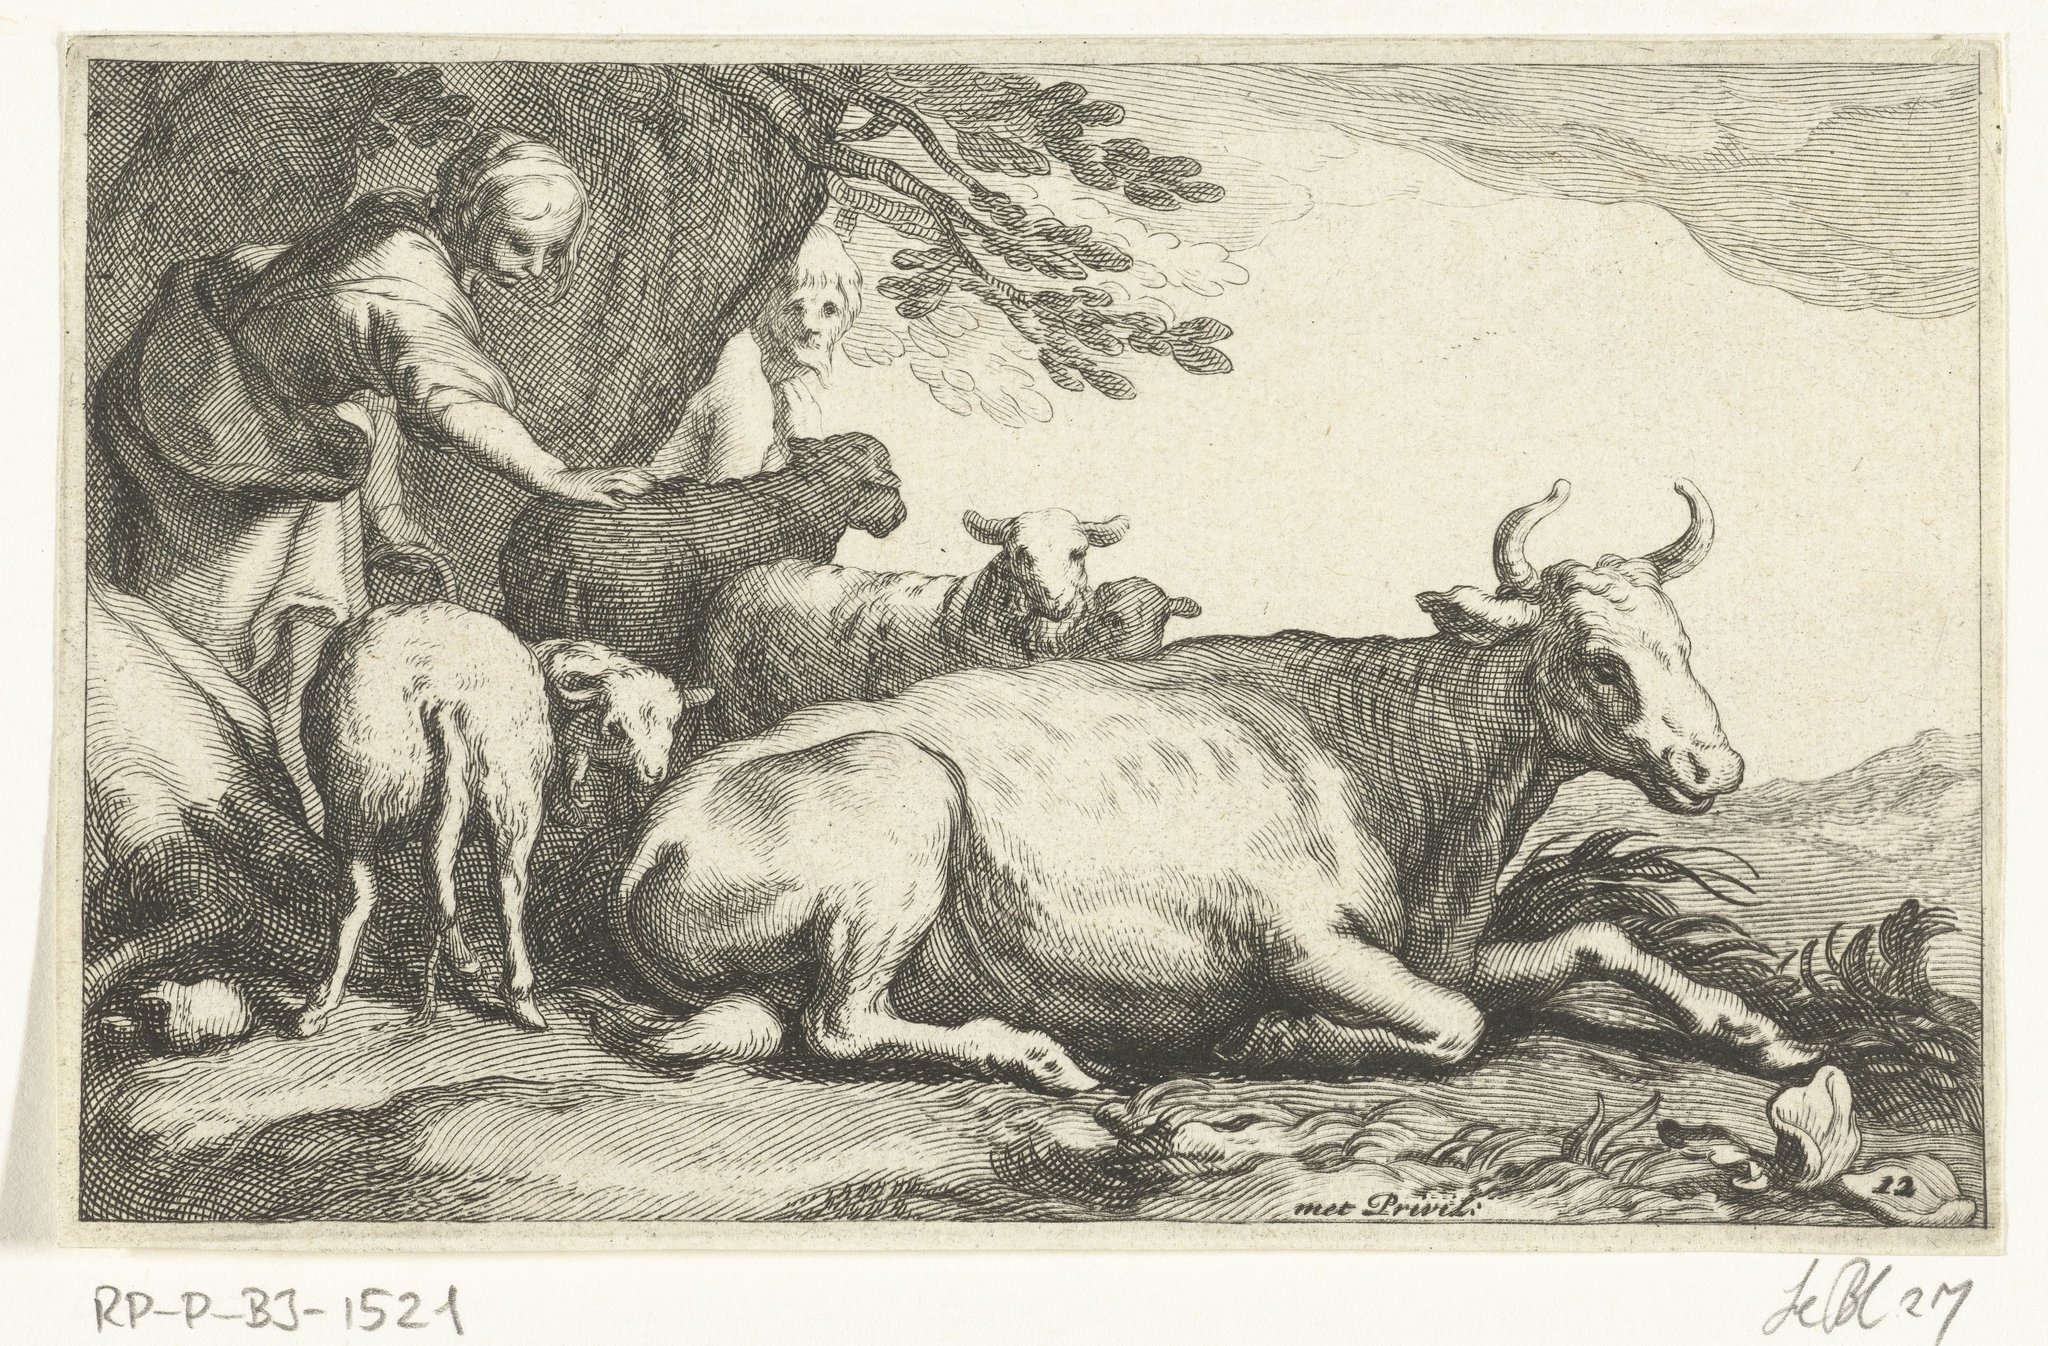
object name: print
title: Dieren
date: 1635-1670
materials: paper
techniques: engraving, etching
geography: amsterdam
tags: cow, pastorals, arcadian scenes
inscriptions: collector's mark: Lugt 240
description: Een herder en een herderin met een kudde bestaande uit schapen en koeien. Prent uit een serie van 14 prenten met verschillende inheemse dieren.